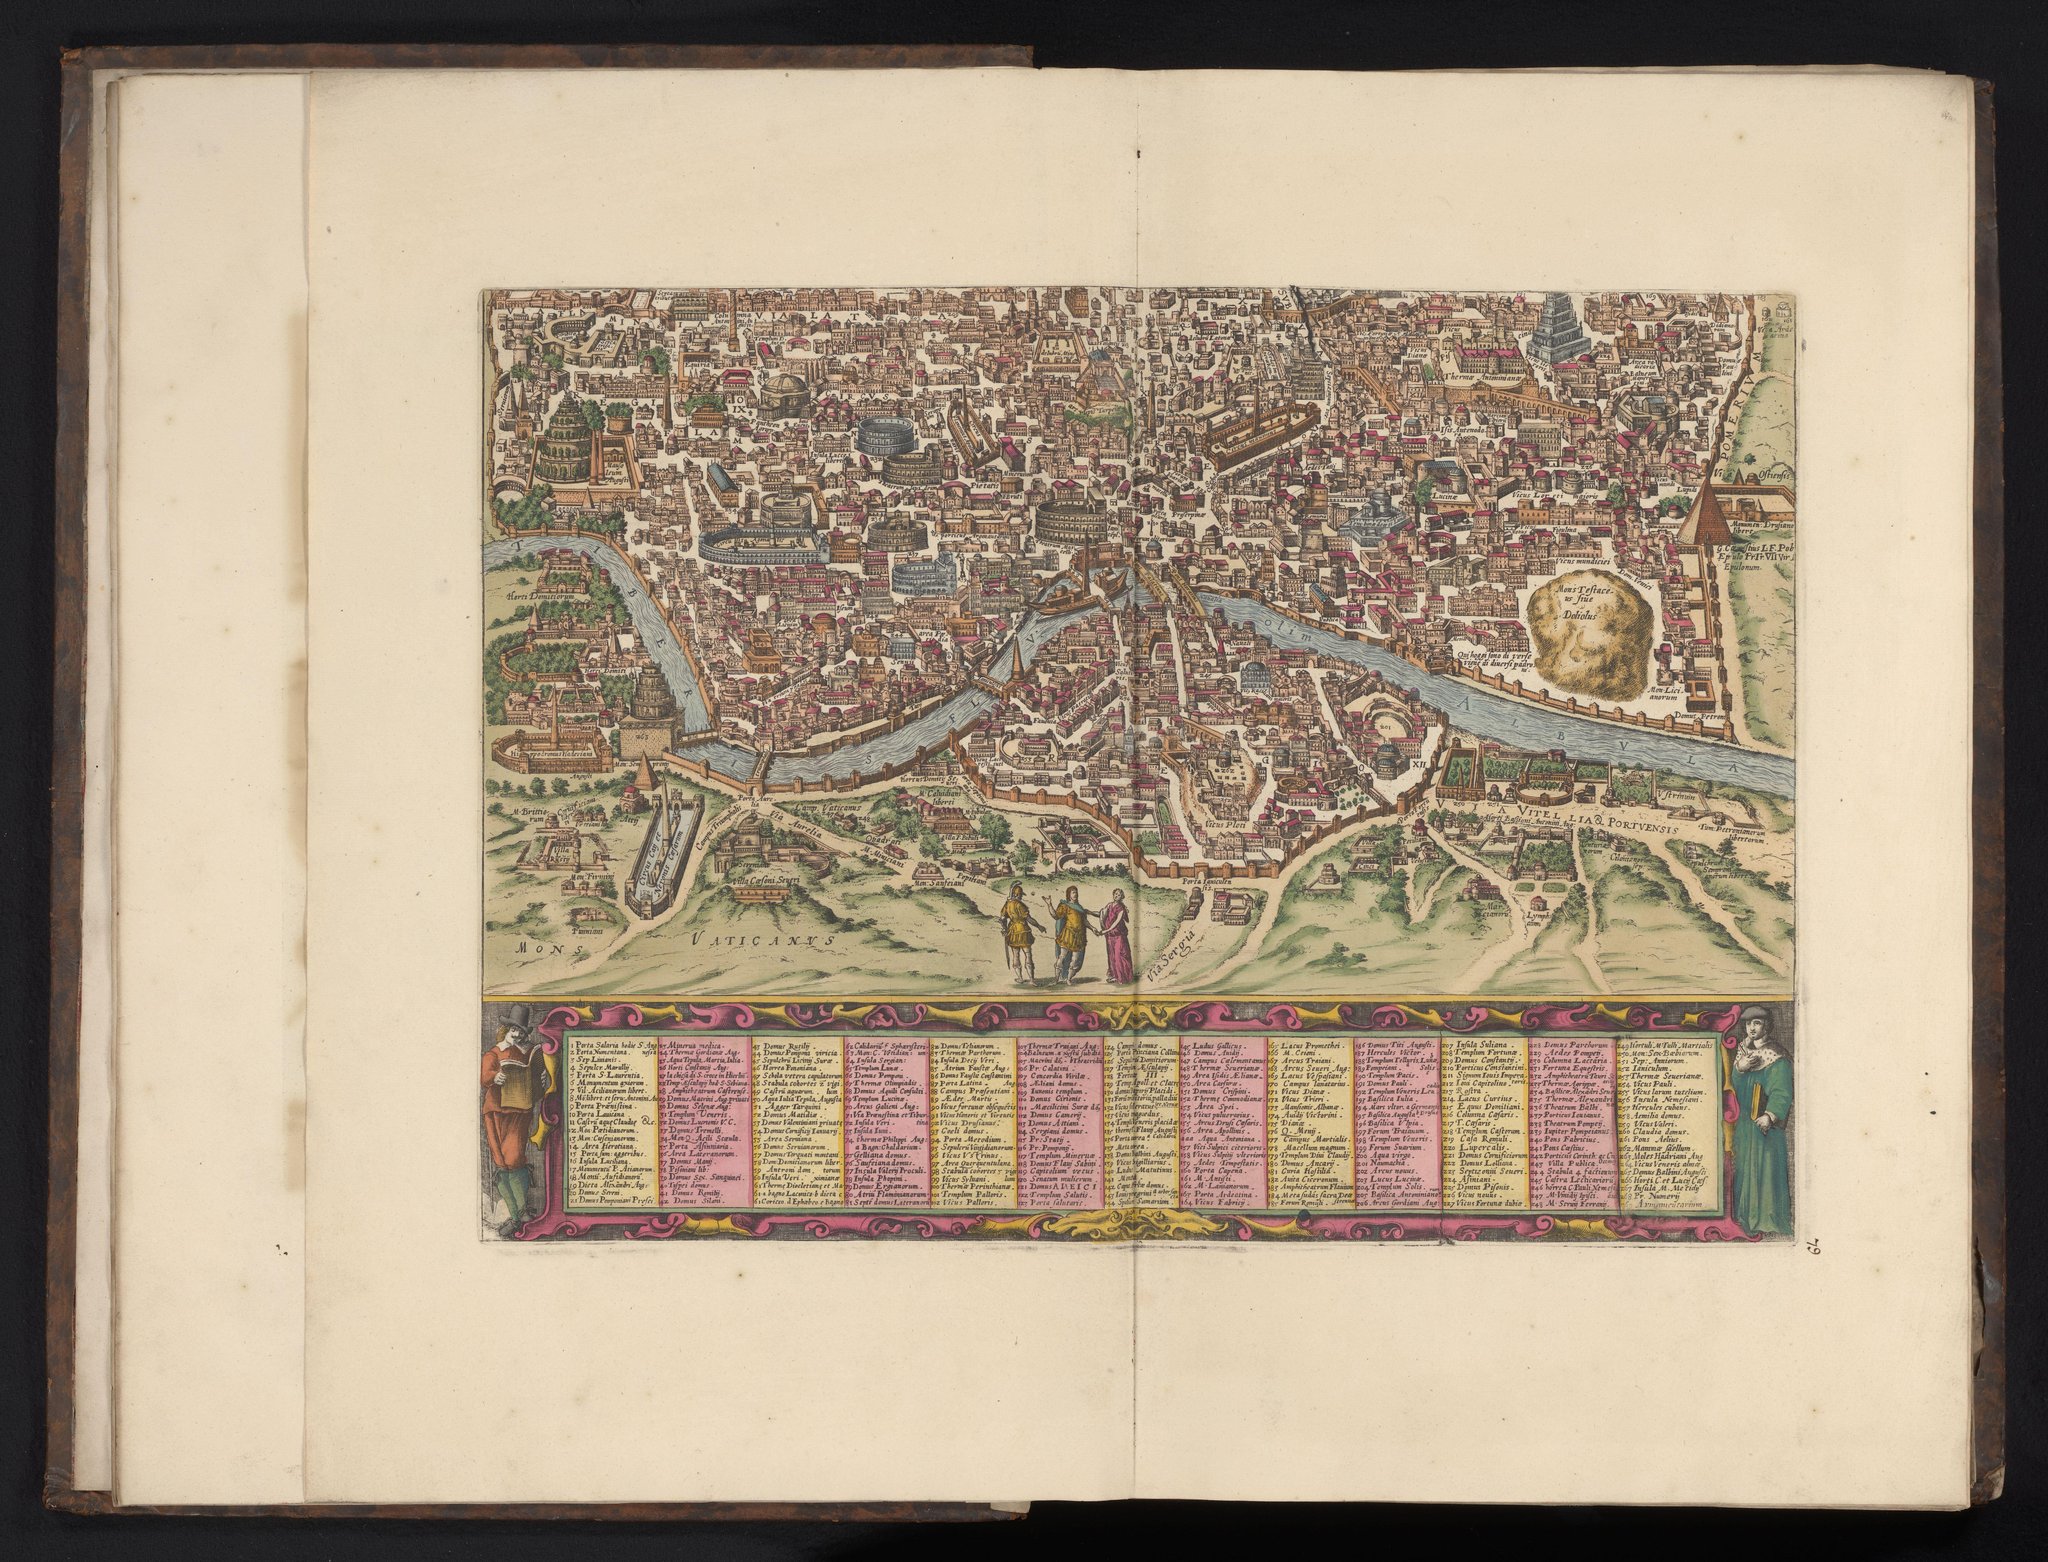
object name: album leaf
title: Antiquae urbis Romae imago accuratiss (...)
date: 1588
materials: paper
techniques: colour, engraving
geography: italy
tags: bird's eye view ~ architectural design or model, maps of cities, rome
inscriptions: number: ‘79’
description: Prent origineel vervaardigd als boekillustratie voor: Georg Braun en Frans Hogenberg. Civitates Orbis Terrarum, 6 delen. Keulen: 1572-1617. De prent werd voor het eerst gepubliceerd in deel 4: Liber quartus urbium praecipuarum totius mundi, 1588.